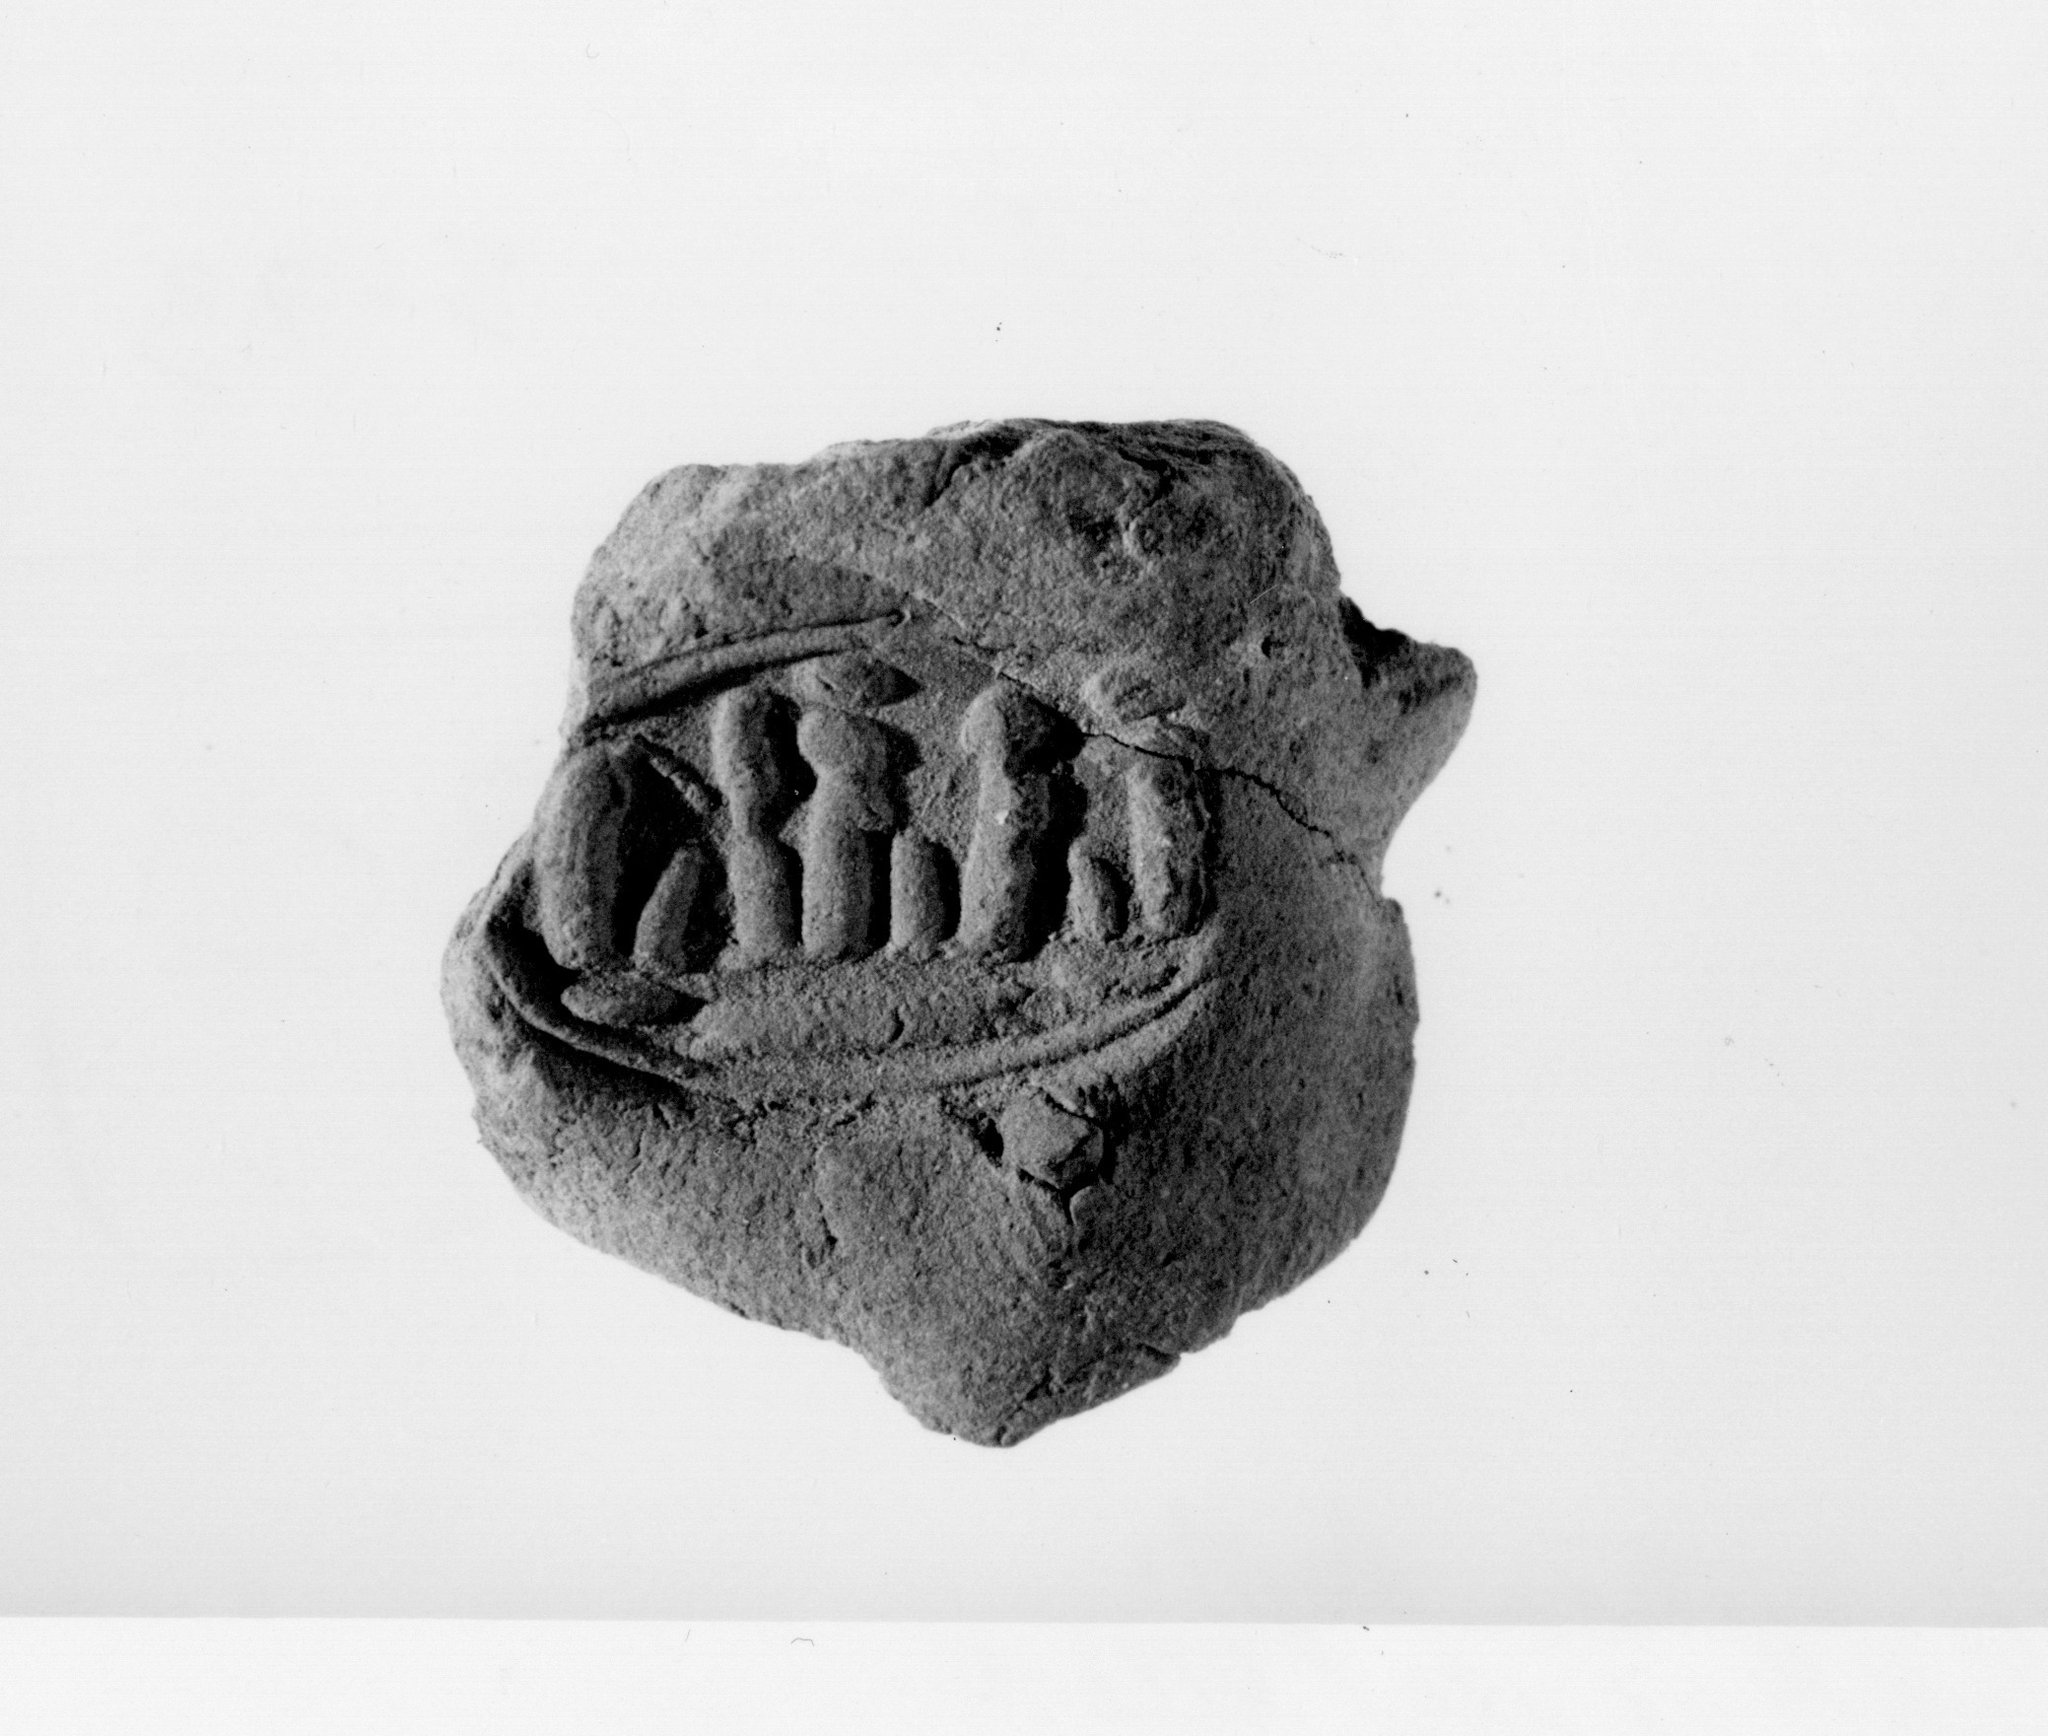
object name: sealing, nebmaatre, amenhotep iii, thoth, ptah, sakhmet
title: Document Sealing With the Throne Name of Amenhotep III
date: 1390-1352 BCE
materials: mud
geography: egypt